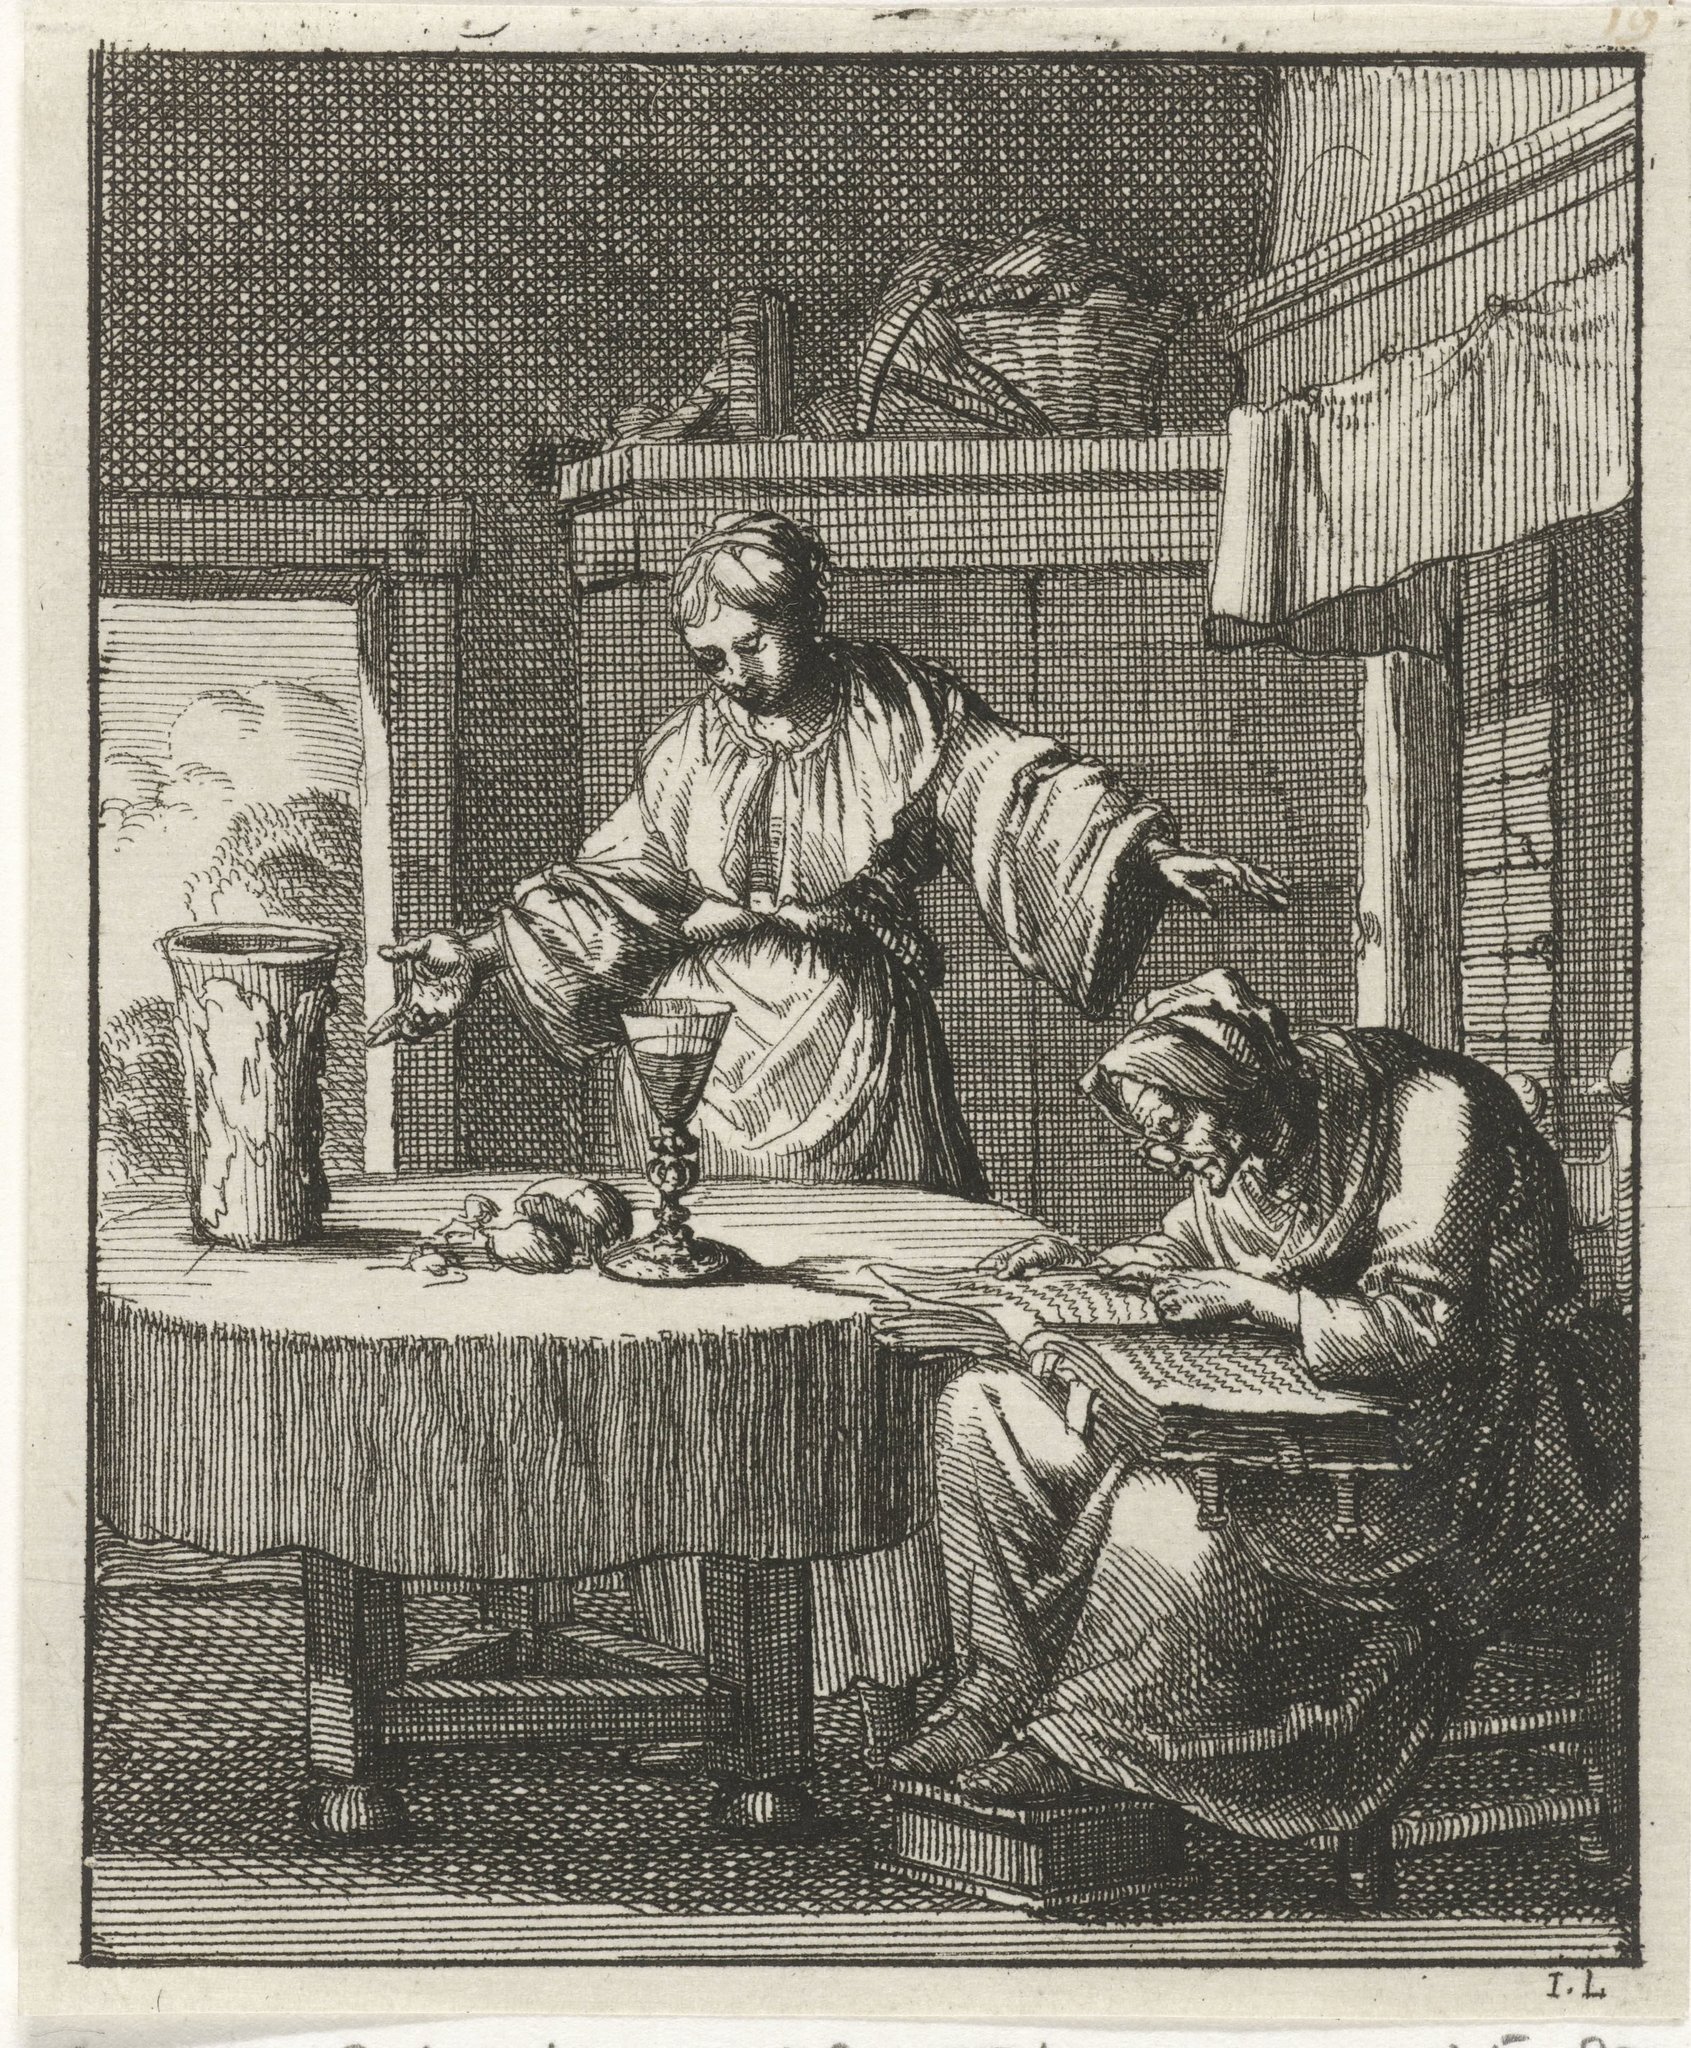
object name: print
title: Vrouw staande bij een tafel waaraan een oude vrouw de bijbel bestudeerd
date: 1687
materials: paper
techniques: etching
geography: amsterdam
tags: reading the bible or other religious books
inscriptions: number: ‘19’, collector's mark: Lugt 2228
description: Illustratie uit: Luyken, Jan. Voncken der liefde Jesu, van het godtbegerende zielenvier. Amsterdam: Pieter Arentsz (II), 1687, p. 76.